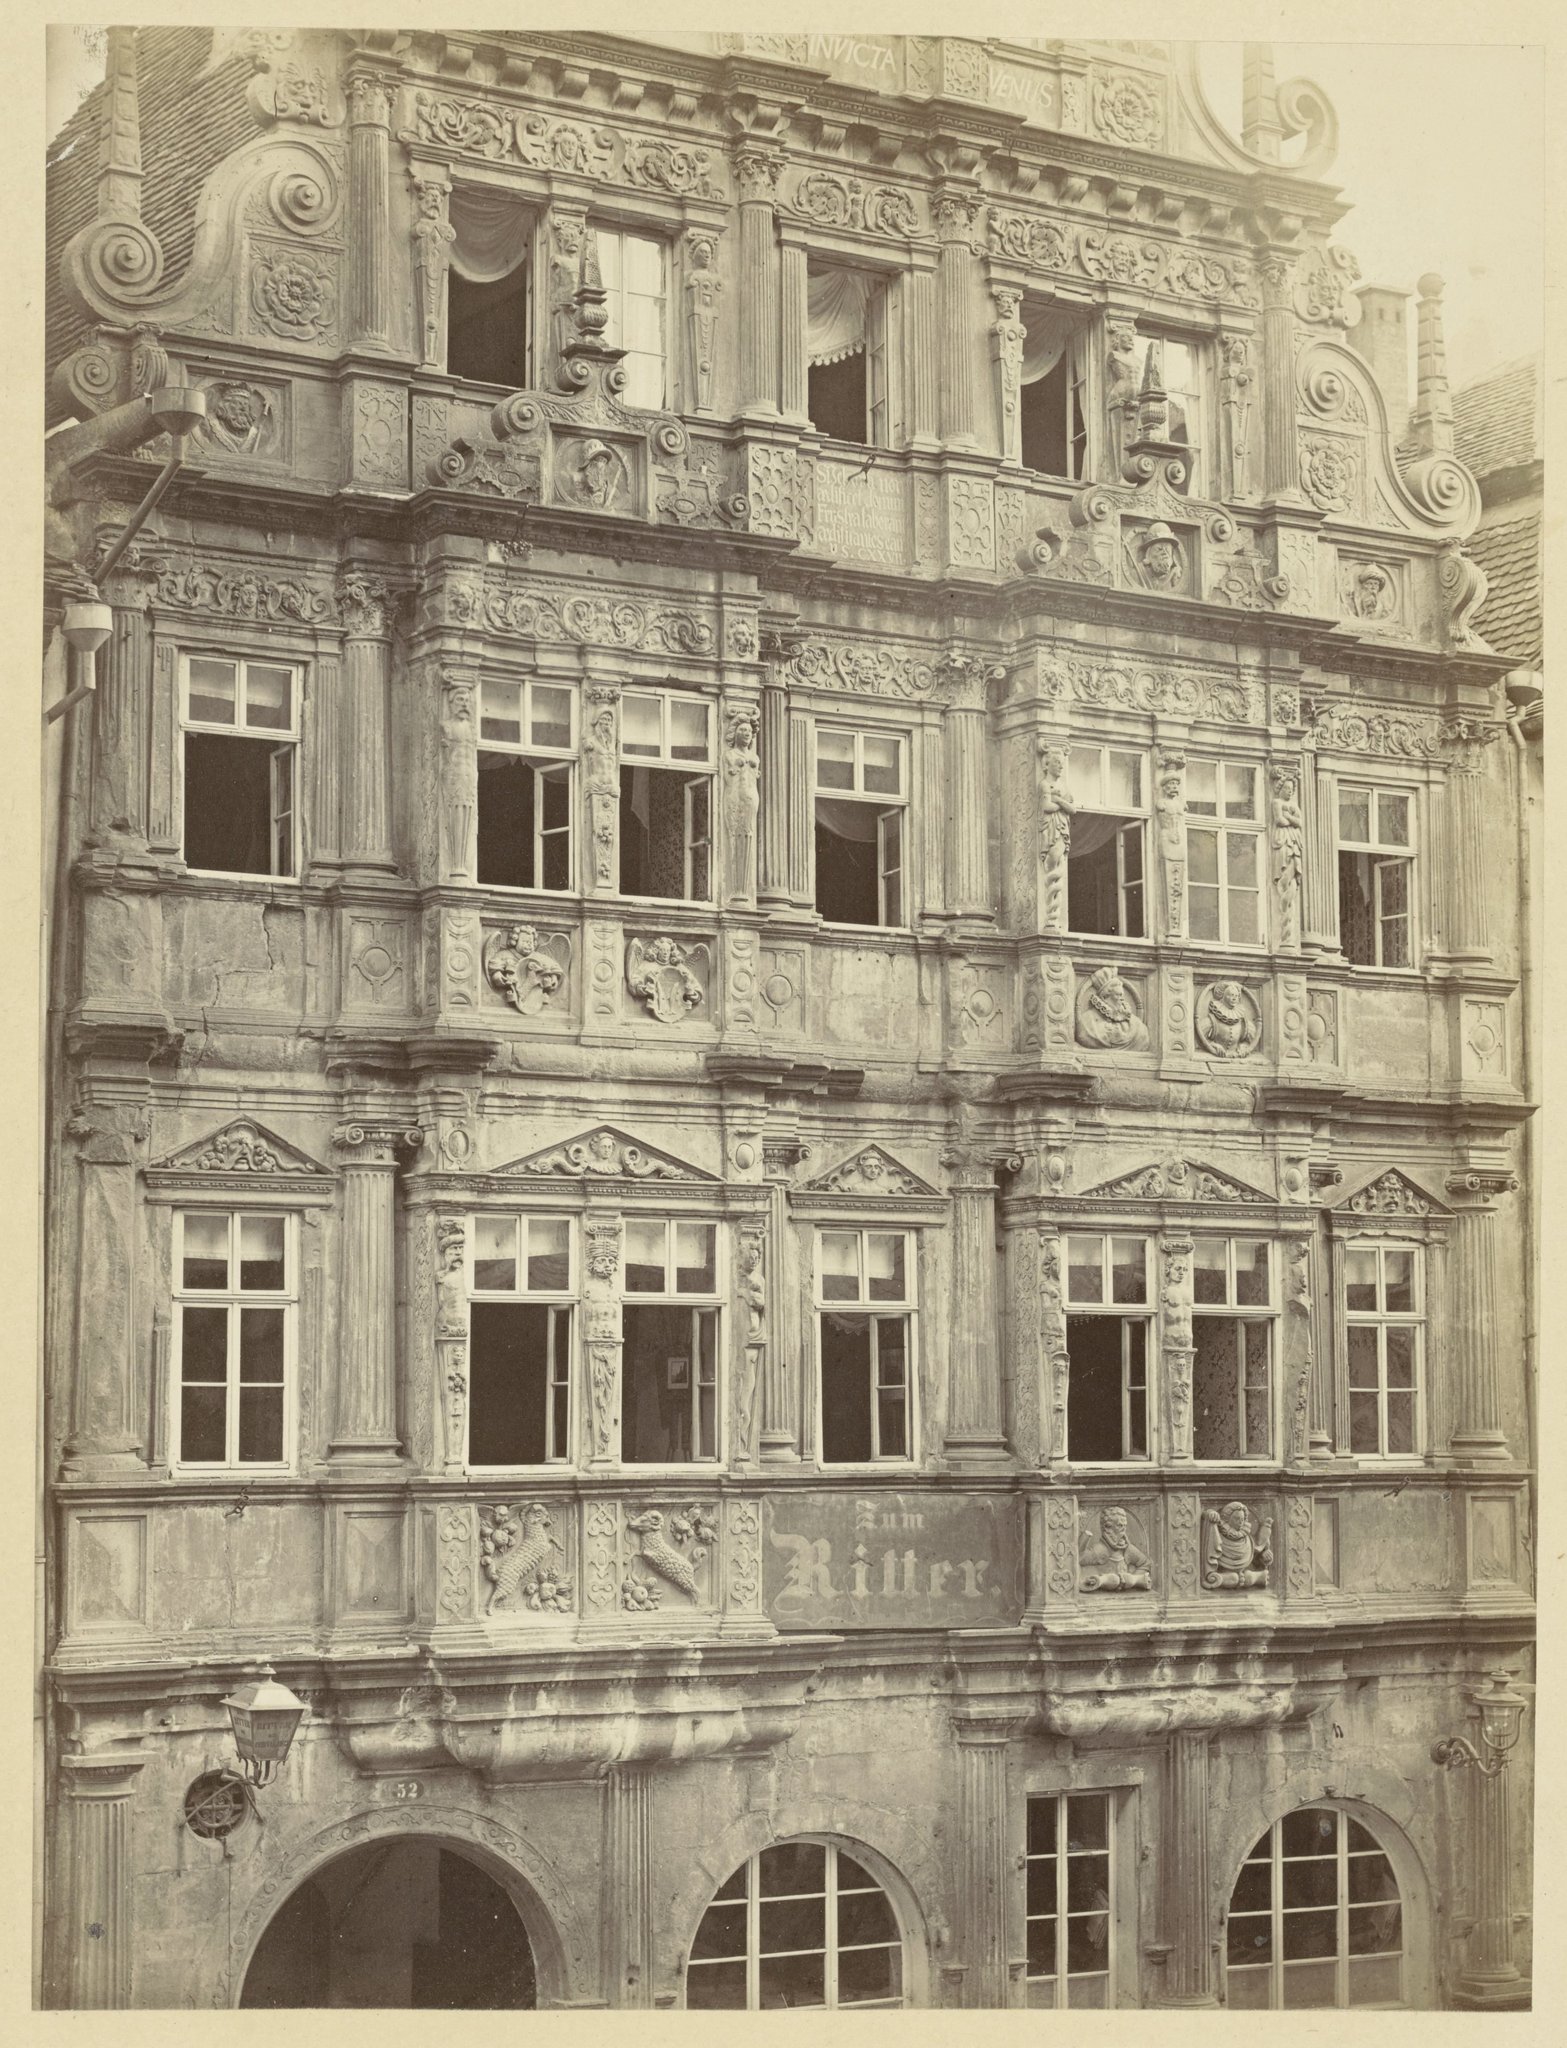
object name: photograph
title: Façade van Haus zum Ritter, Heidelberg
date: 1855-1879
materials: cardboard, paper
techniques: albumen print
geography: heidelberg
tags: front façade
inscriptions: check stamp: ‘Kunst & Musikalienhandlung/ L. Meder/ Heidelberg’, number: ‘98 d.’, collector's mark: Lugt 3937